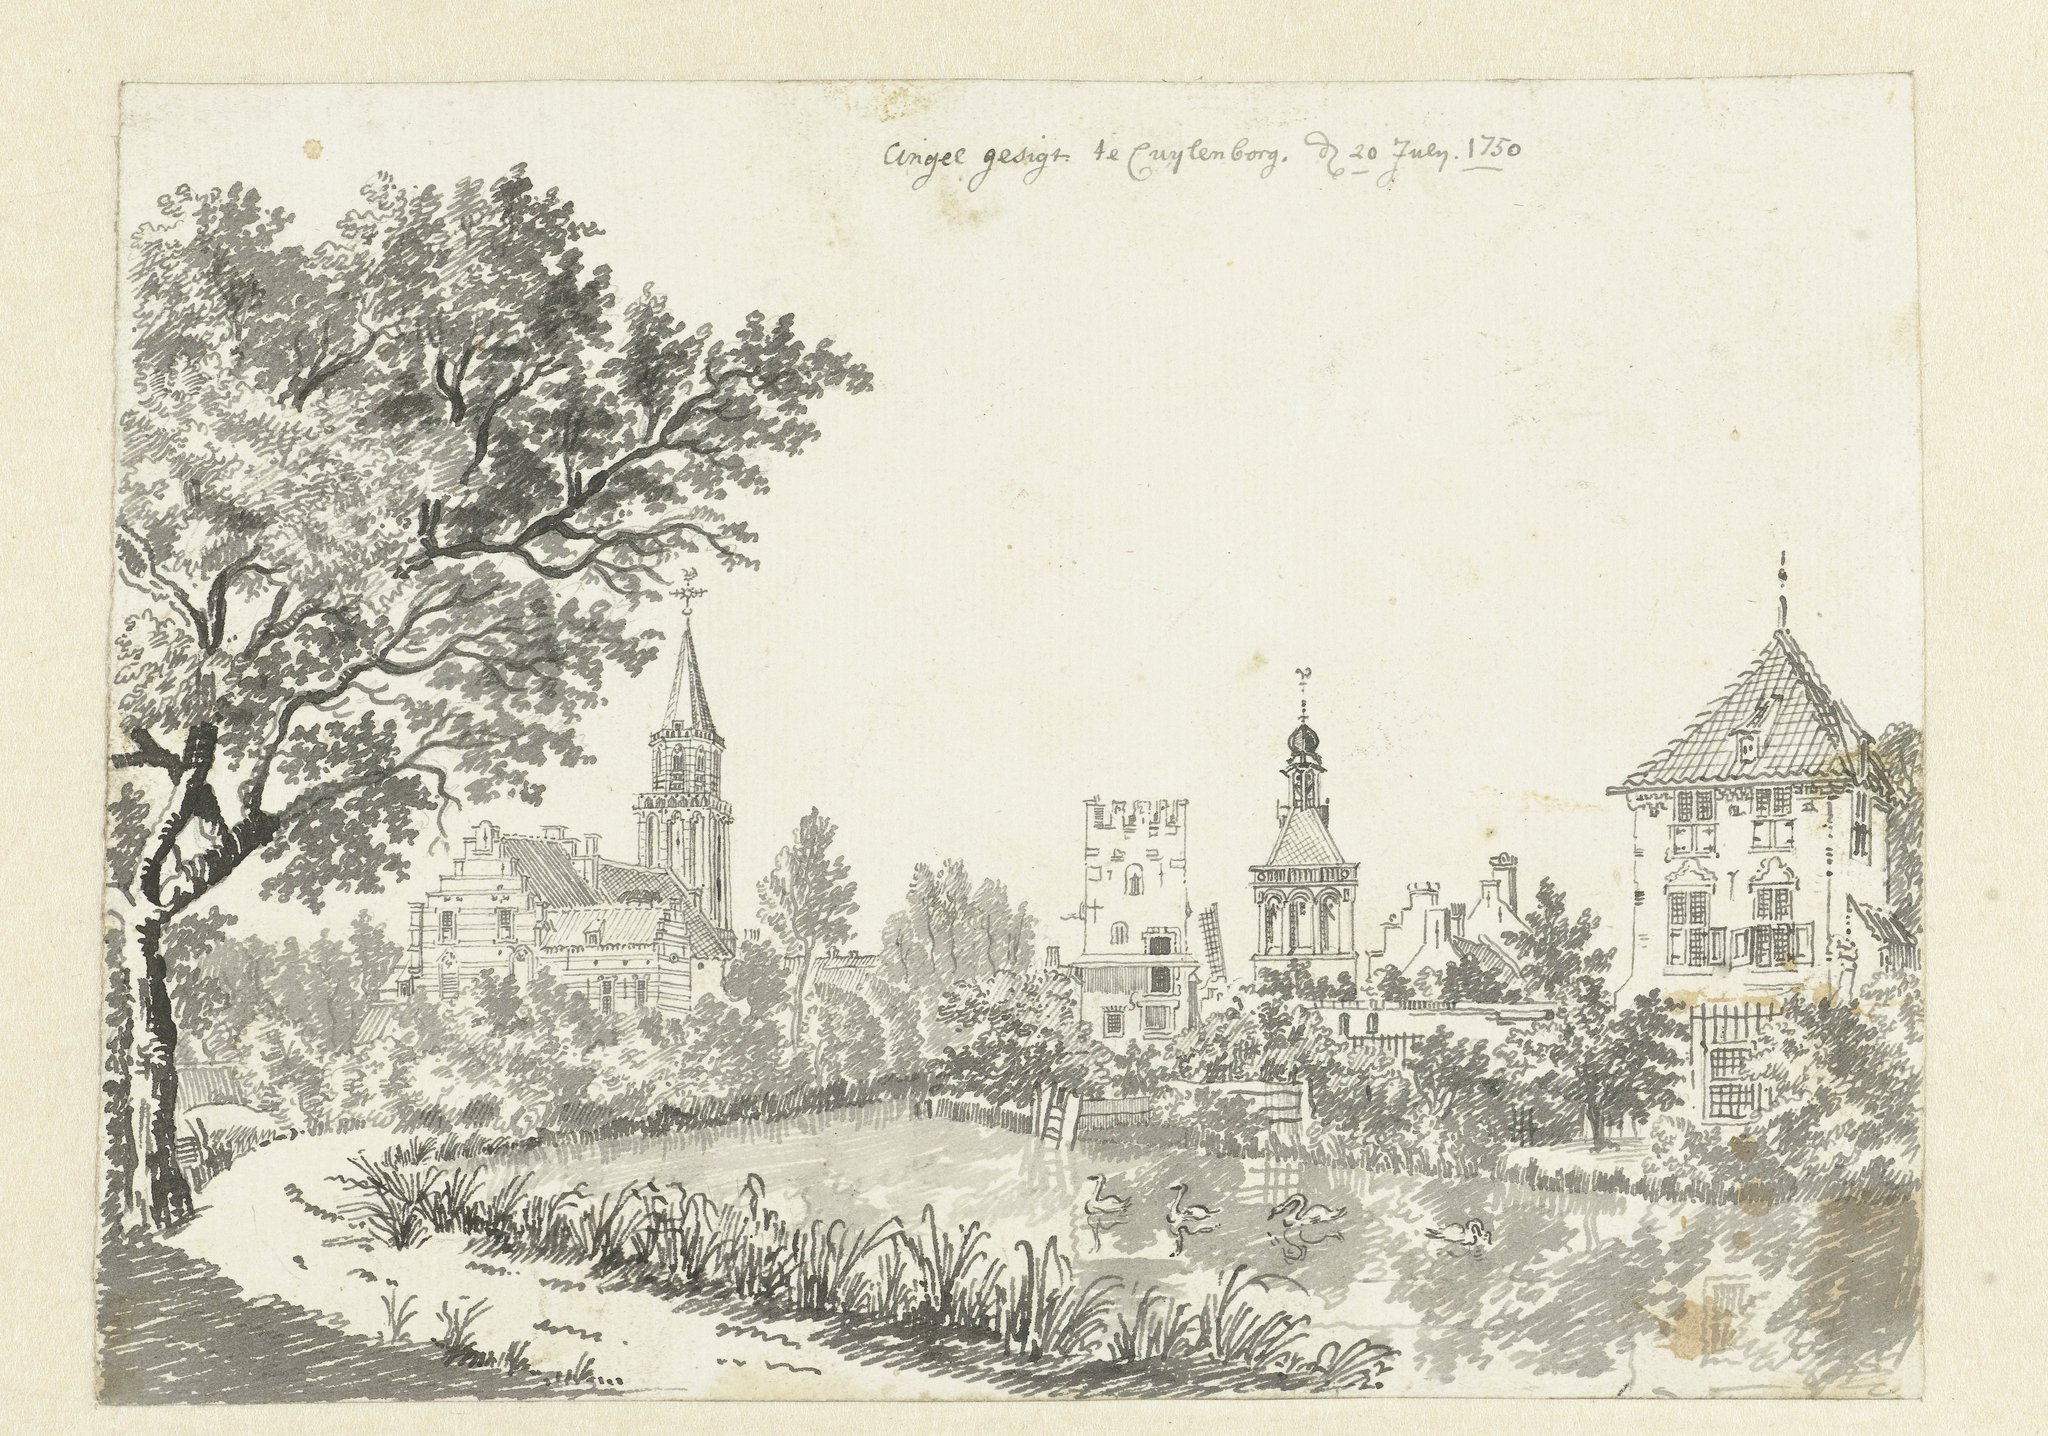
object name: drawing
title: Gezicht te Culemborg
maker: jan de beijer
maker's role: draughtsman, print maker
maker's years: 1703-1780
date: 1750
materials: ink, paper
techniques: brush, pen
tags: prospect of city, town panorama, silhouette of city